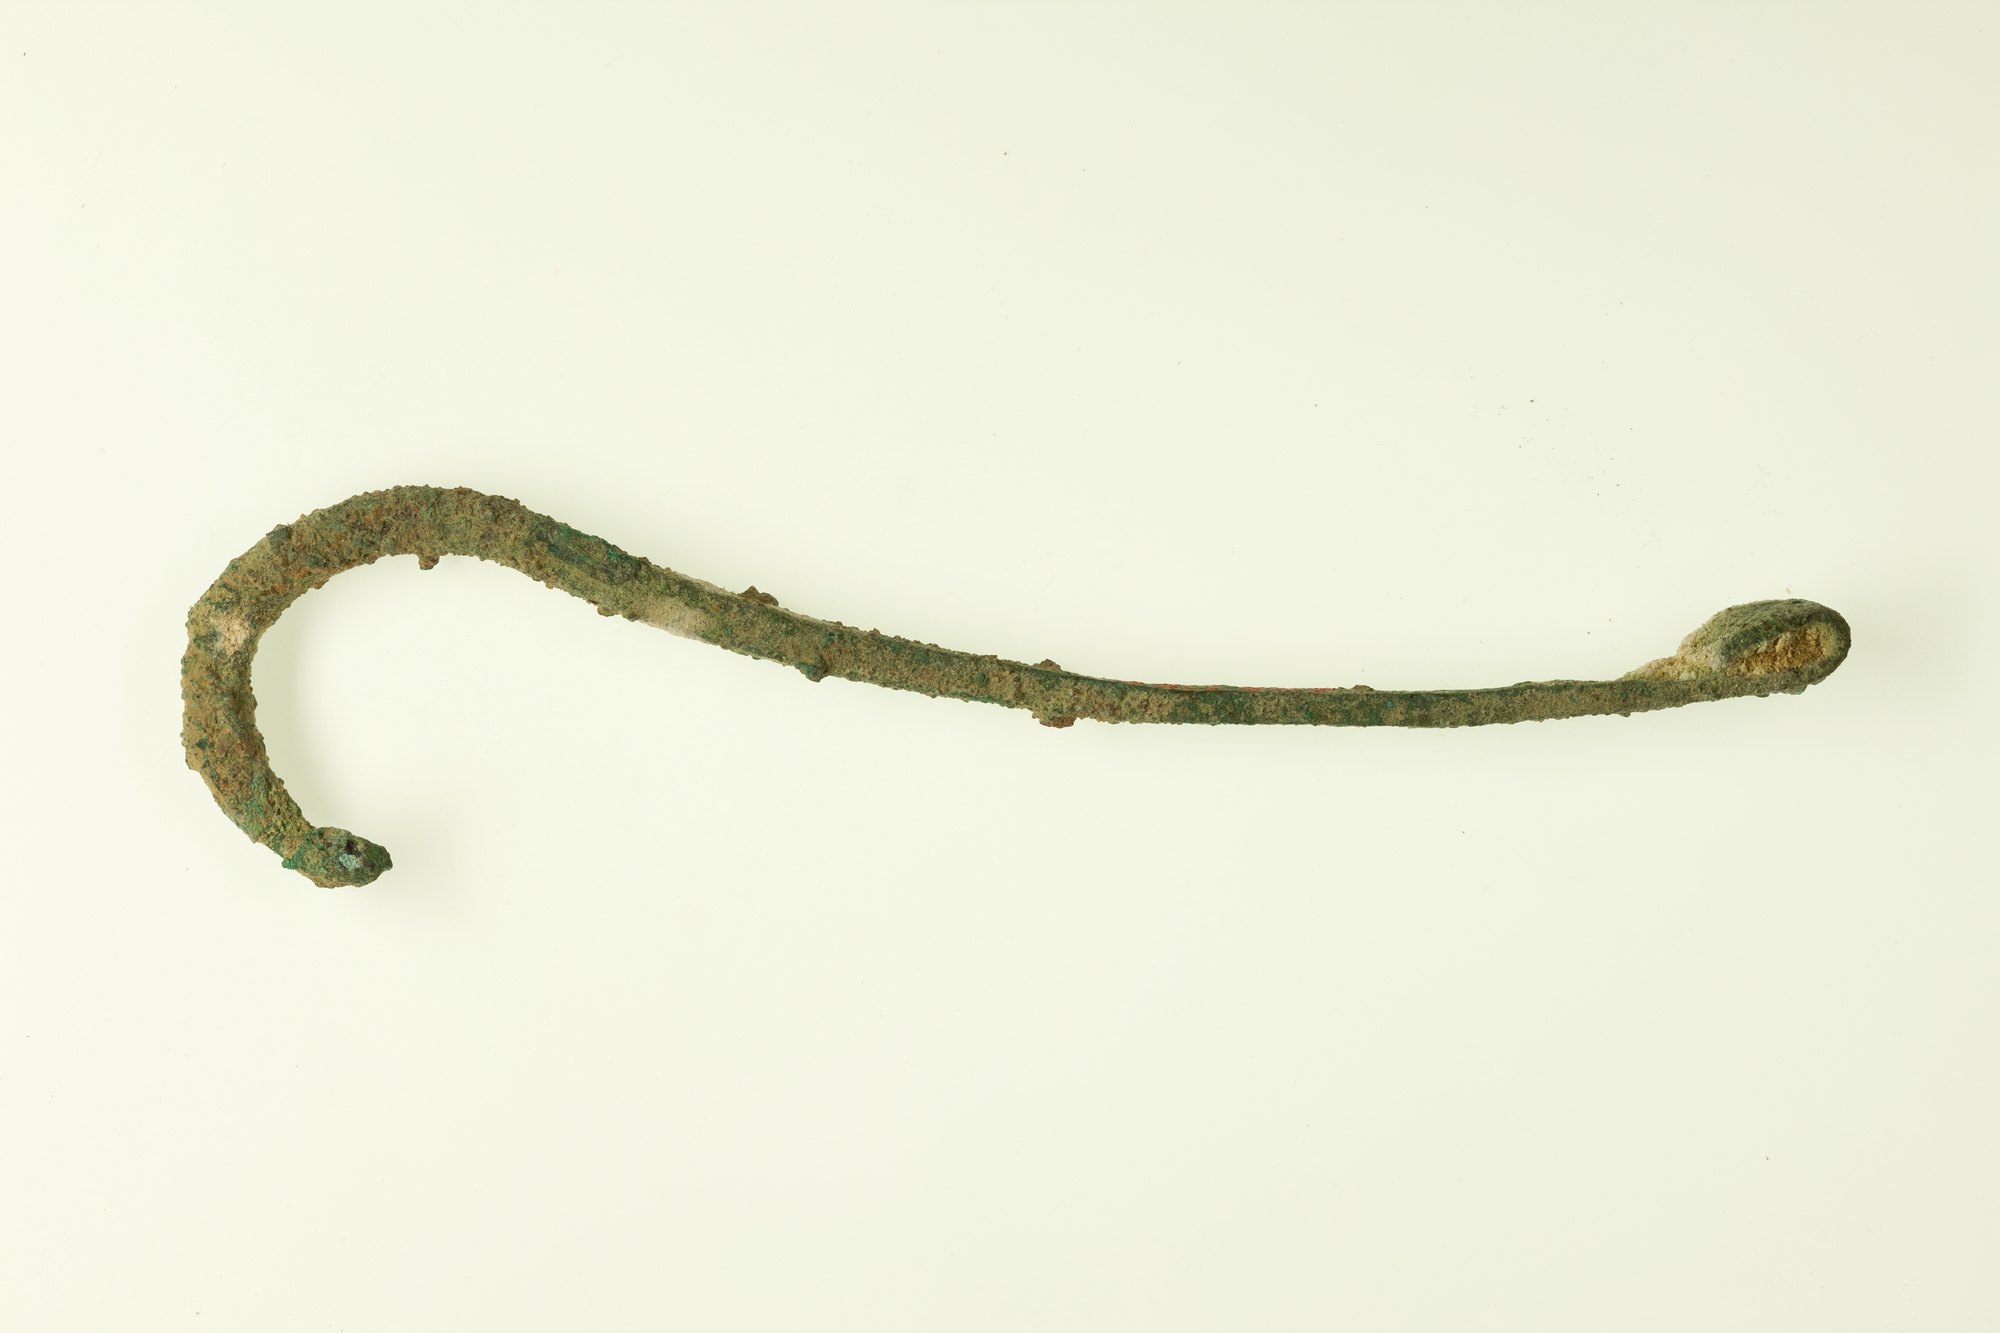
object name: fish hook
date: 1295-1070 BCE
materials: bronze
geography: egypt